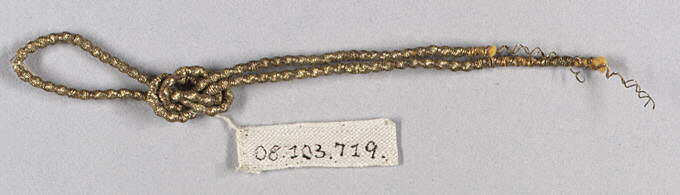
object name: thread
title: Tinsel and metal thread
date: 1601-1800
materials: metal thread